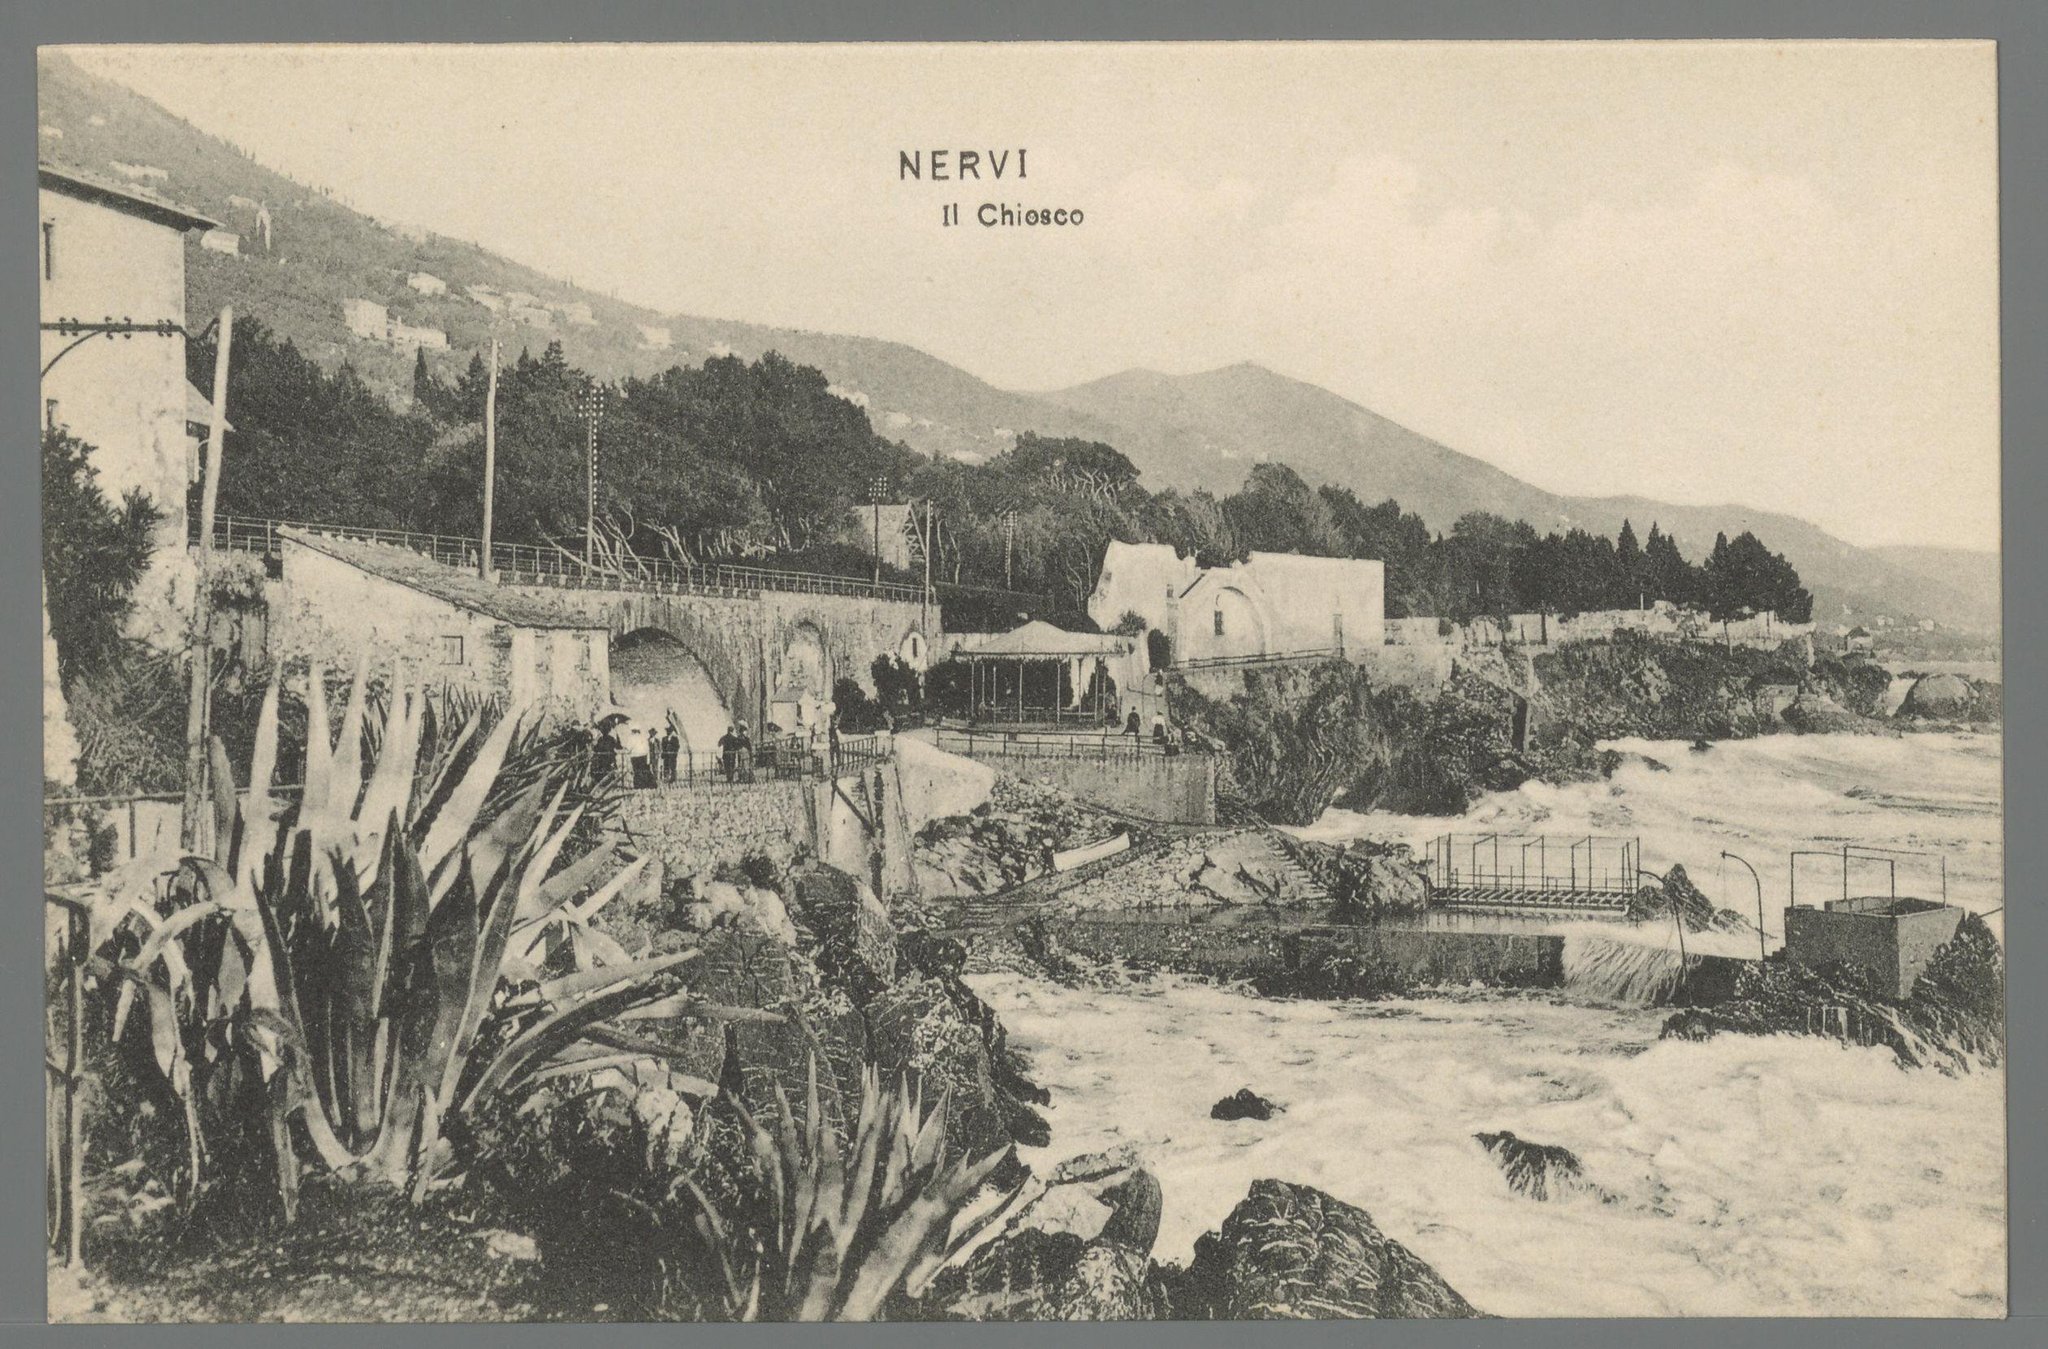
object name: photomechanical print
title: Nervi. Il Chiosco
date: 1908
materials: cardboard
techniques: photograph, writing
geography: leipzig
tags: rocky coast, rural housing, e.g. country-house, villa, cottage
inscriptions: date